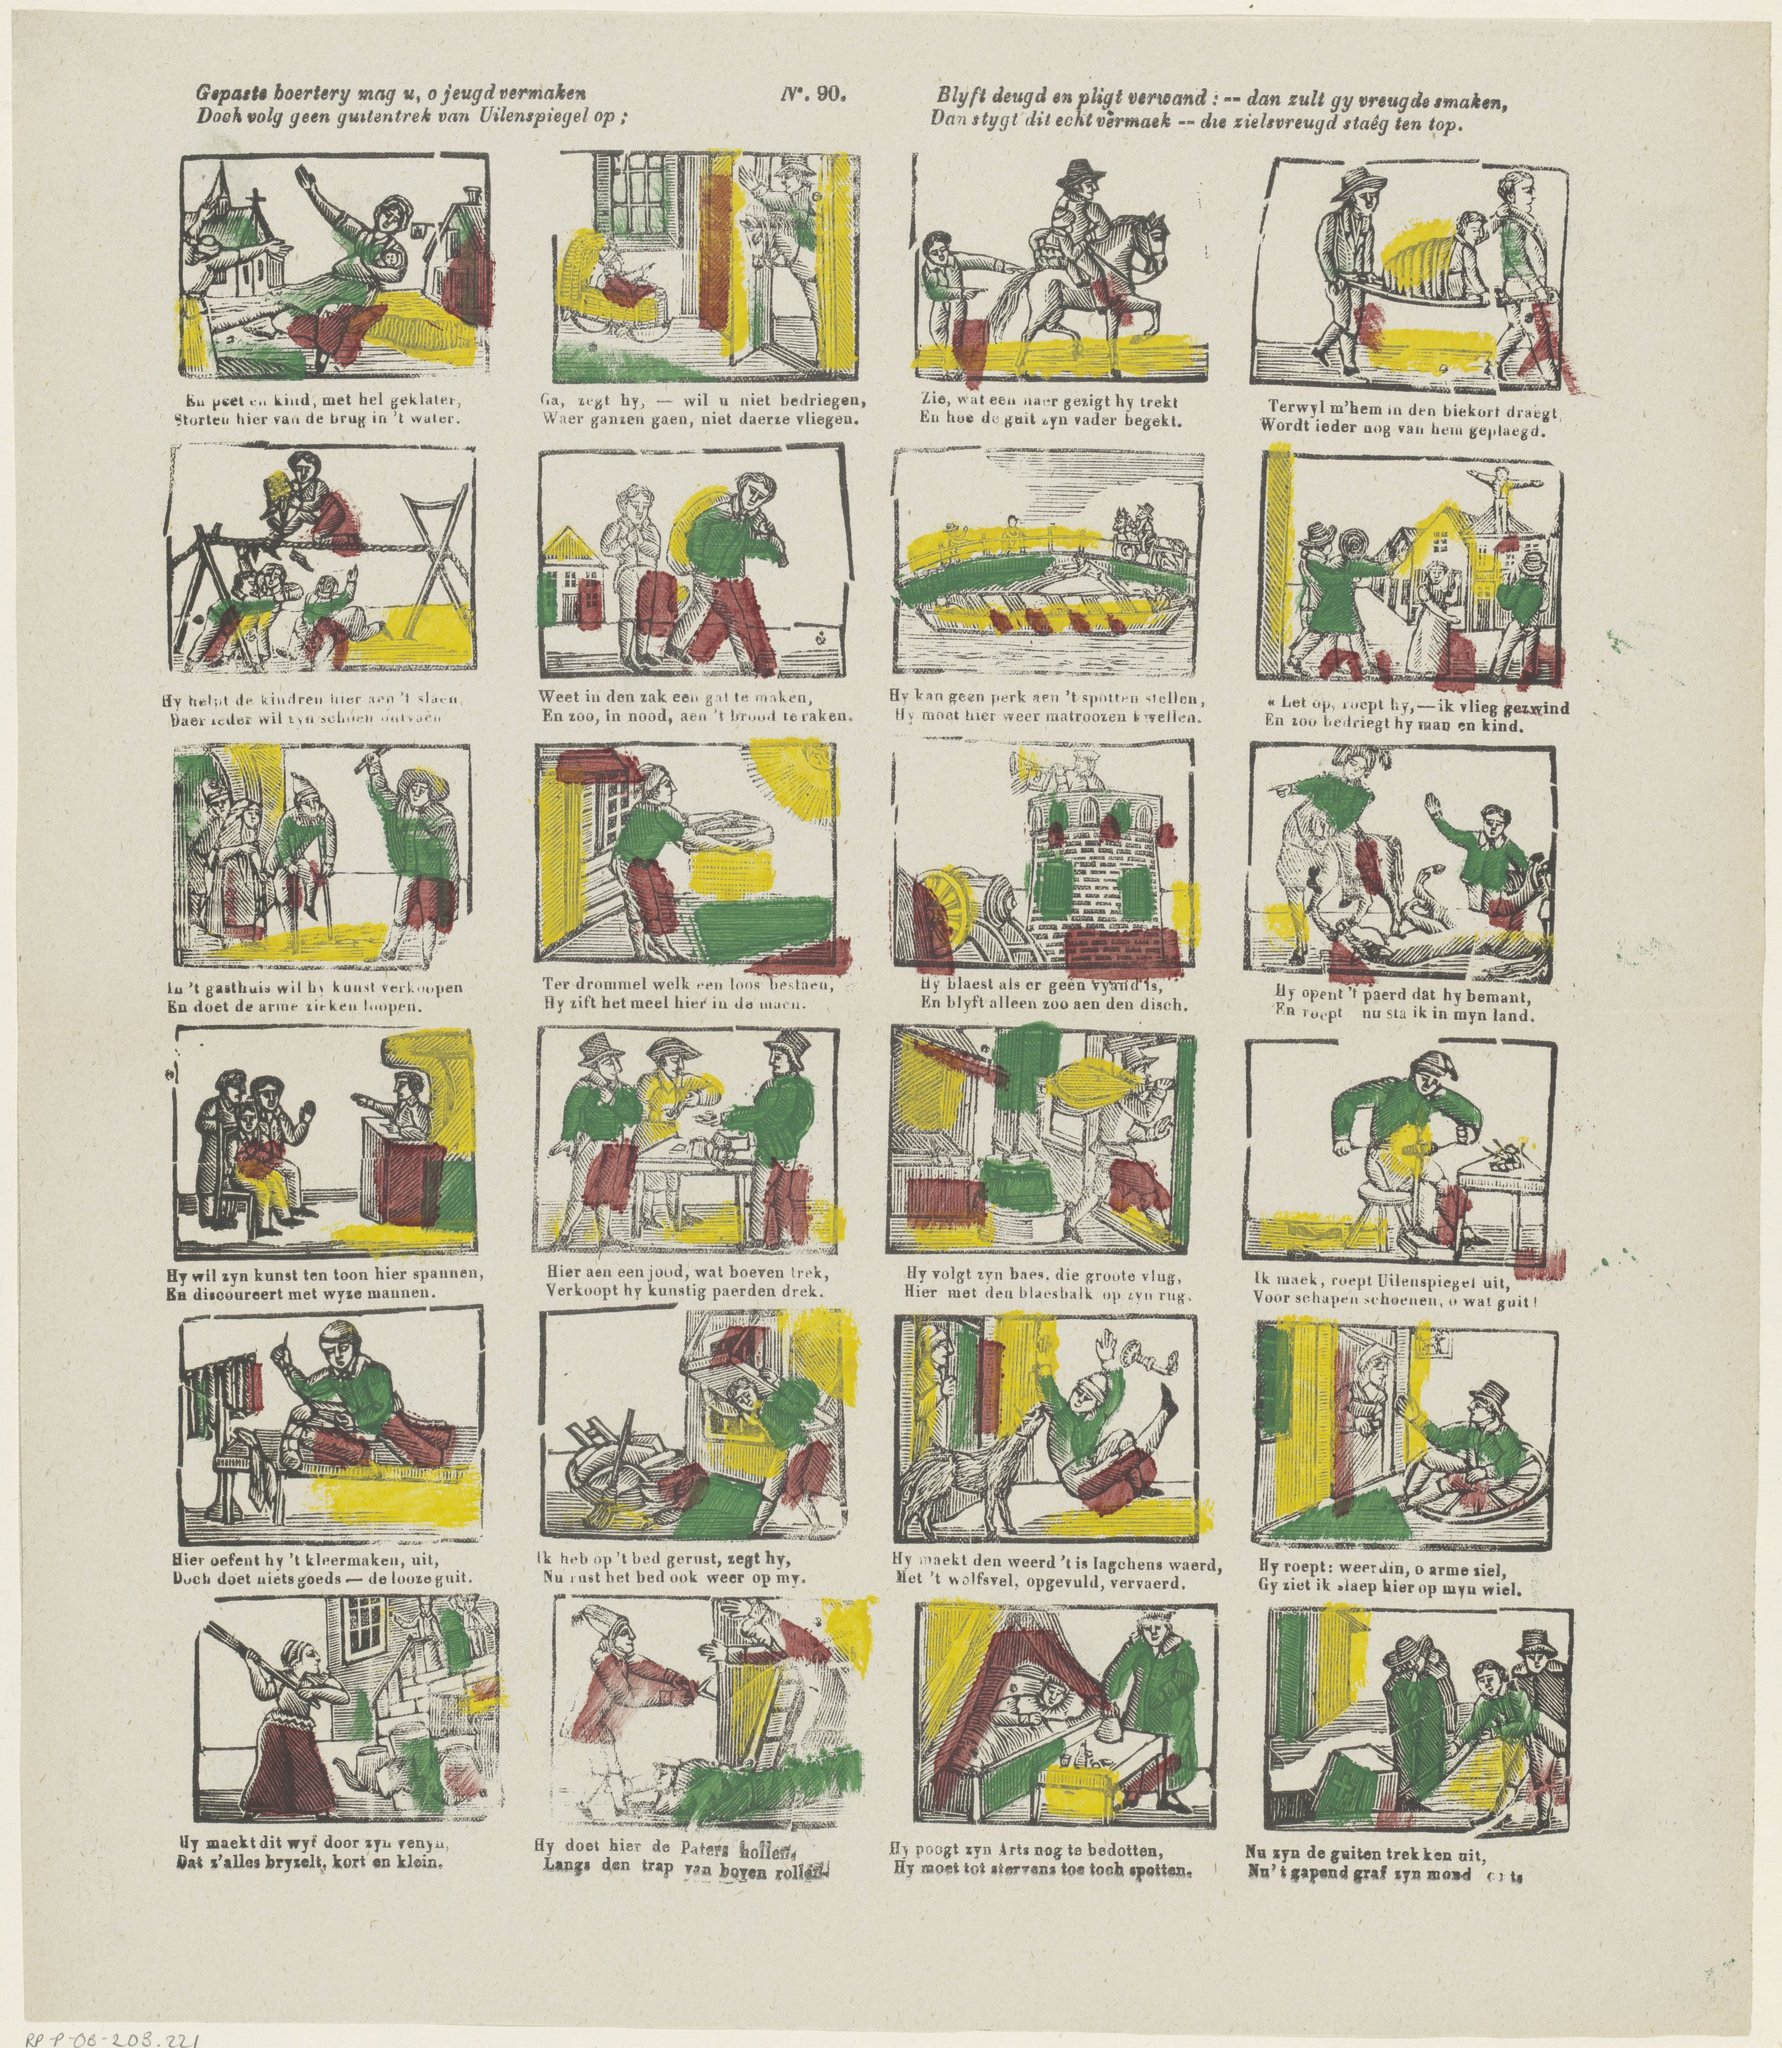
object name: print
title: Gepaste boertery mag u, o jeugd vermaken / Doch volg geen guitentrek van Uilenspiegel op; / Blyf deugd en pligt verwand: -- dan zult gy vreugde smaken, / Dan stygt dit echt vermaek -- die zielsvreugd staêg ten top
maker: Anonymous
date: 1856-1900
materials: paper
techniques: colour, letterpress printing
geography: turnhout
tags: eulenspiegel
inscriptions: collector's mark: Lugt 2760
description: Blad met 24 voorstellingen over het leven van Tijl Uilenspiegel. Onder elke afbeelding een tweeregelig vers. Genummerd midden boven: No. 90.